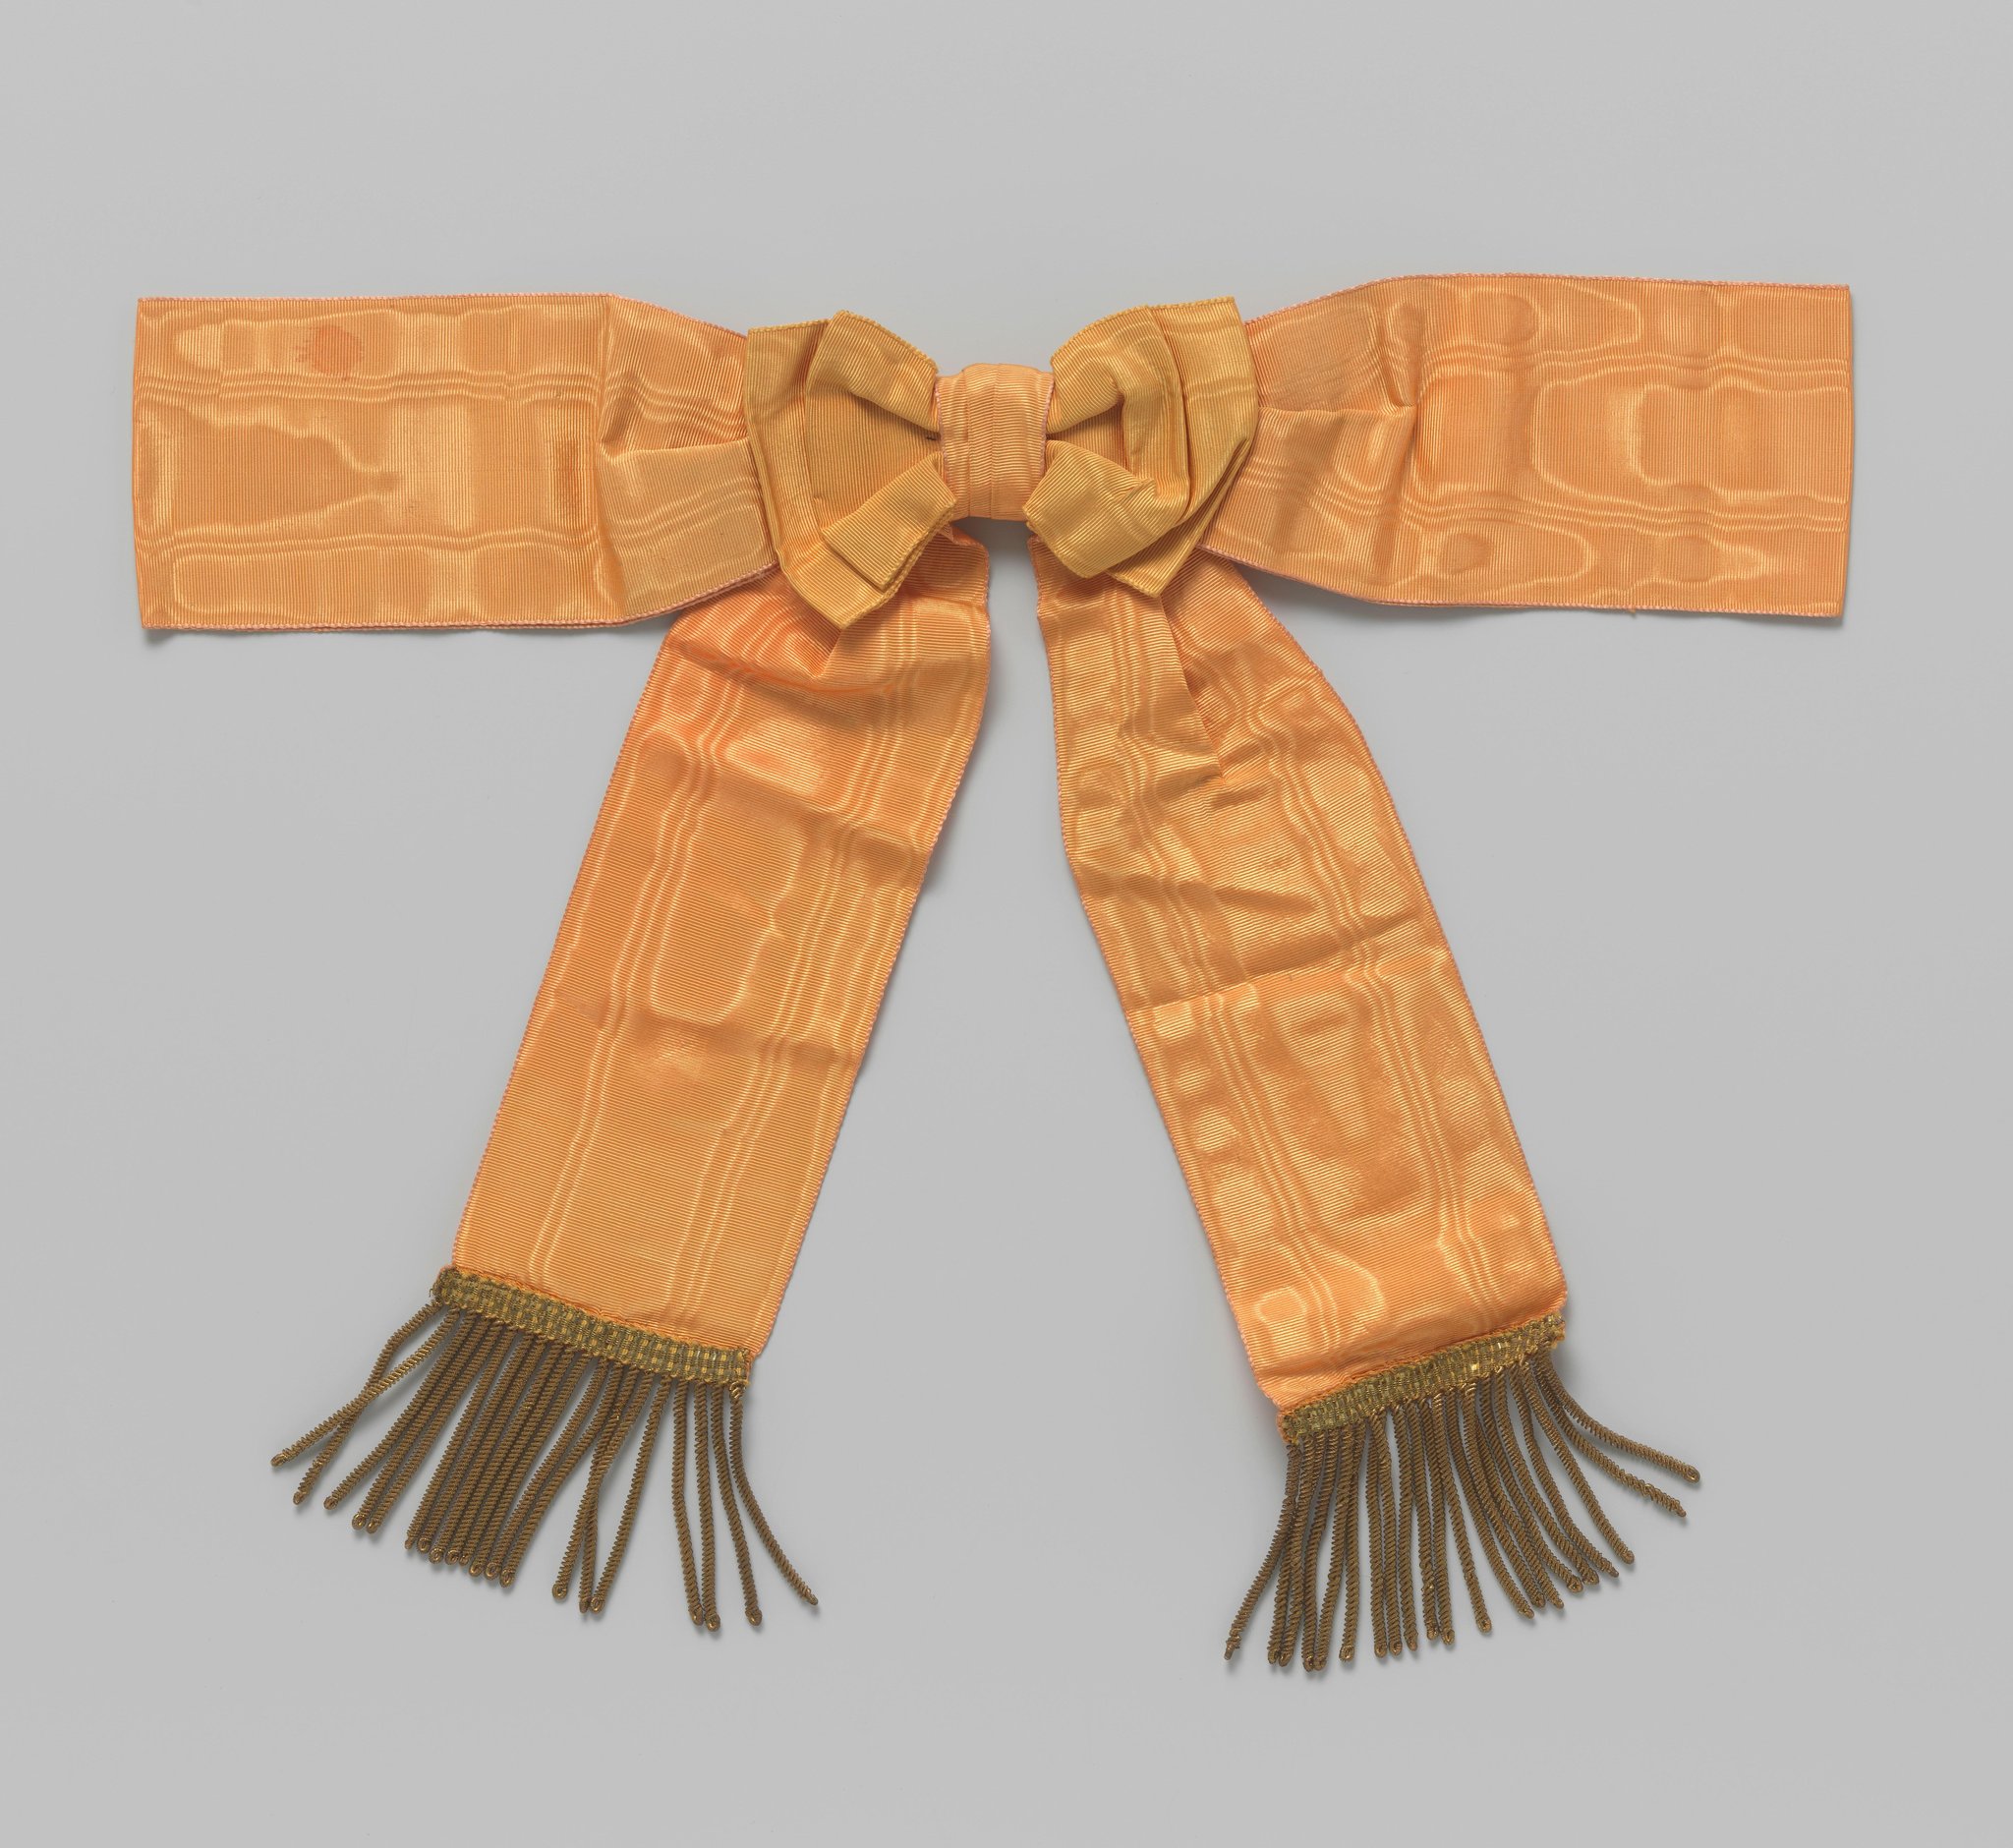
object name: clothing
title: Schouderstrik van oranje moiré-lint met franje van gouddraad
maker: Anonymous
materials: gold thread, metal, silk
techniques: weave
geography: amsterdam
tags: amsterdam, jonkheer jan six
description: Schouderstrik van oranje moiré-lint met franje van gouddraad, gedragen op de hofrok door leden van de erewacht, bij de inhuldiging van koningin Wilhelmina in 1898. Het lint is in een middenstrik genaaid met een paar extra lange lussen en uiteinden die met goudfranje zijn afgewerkt.